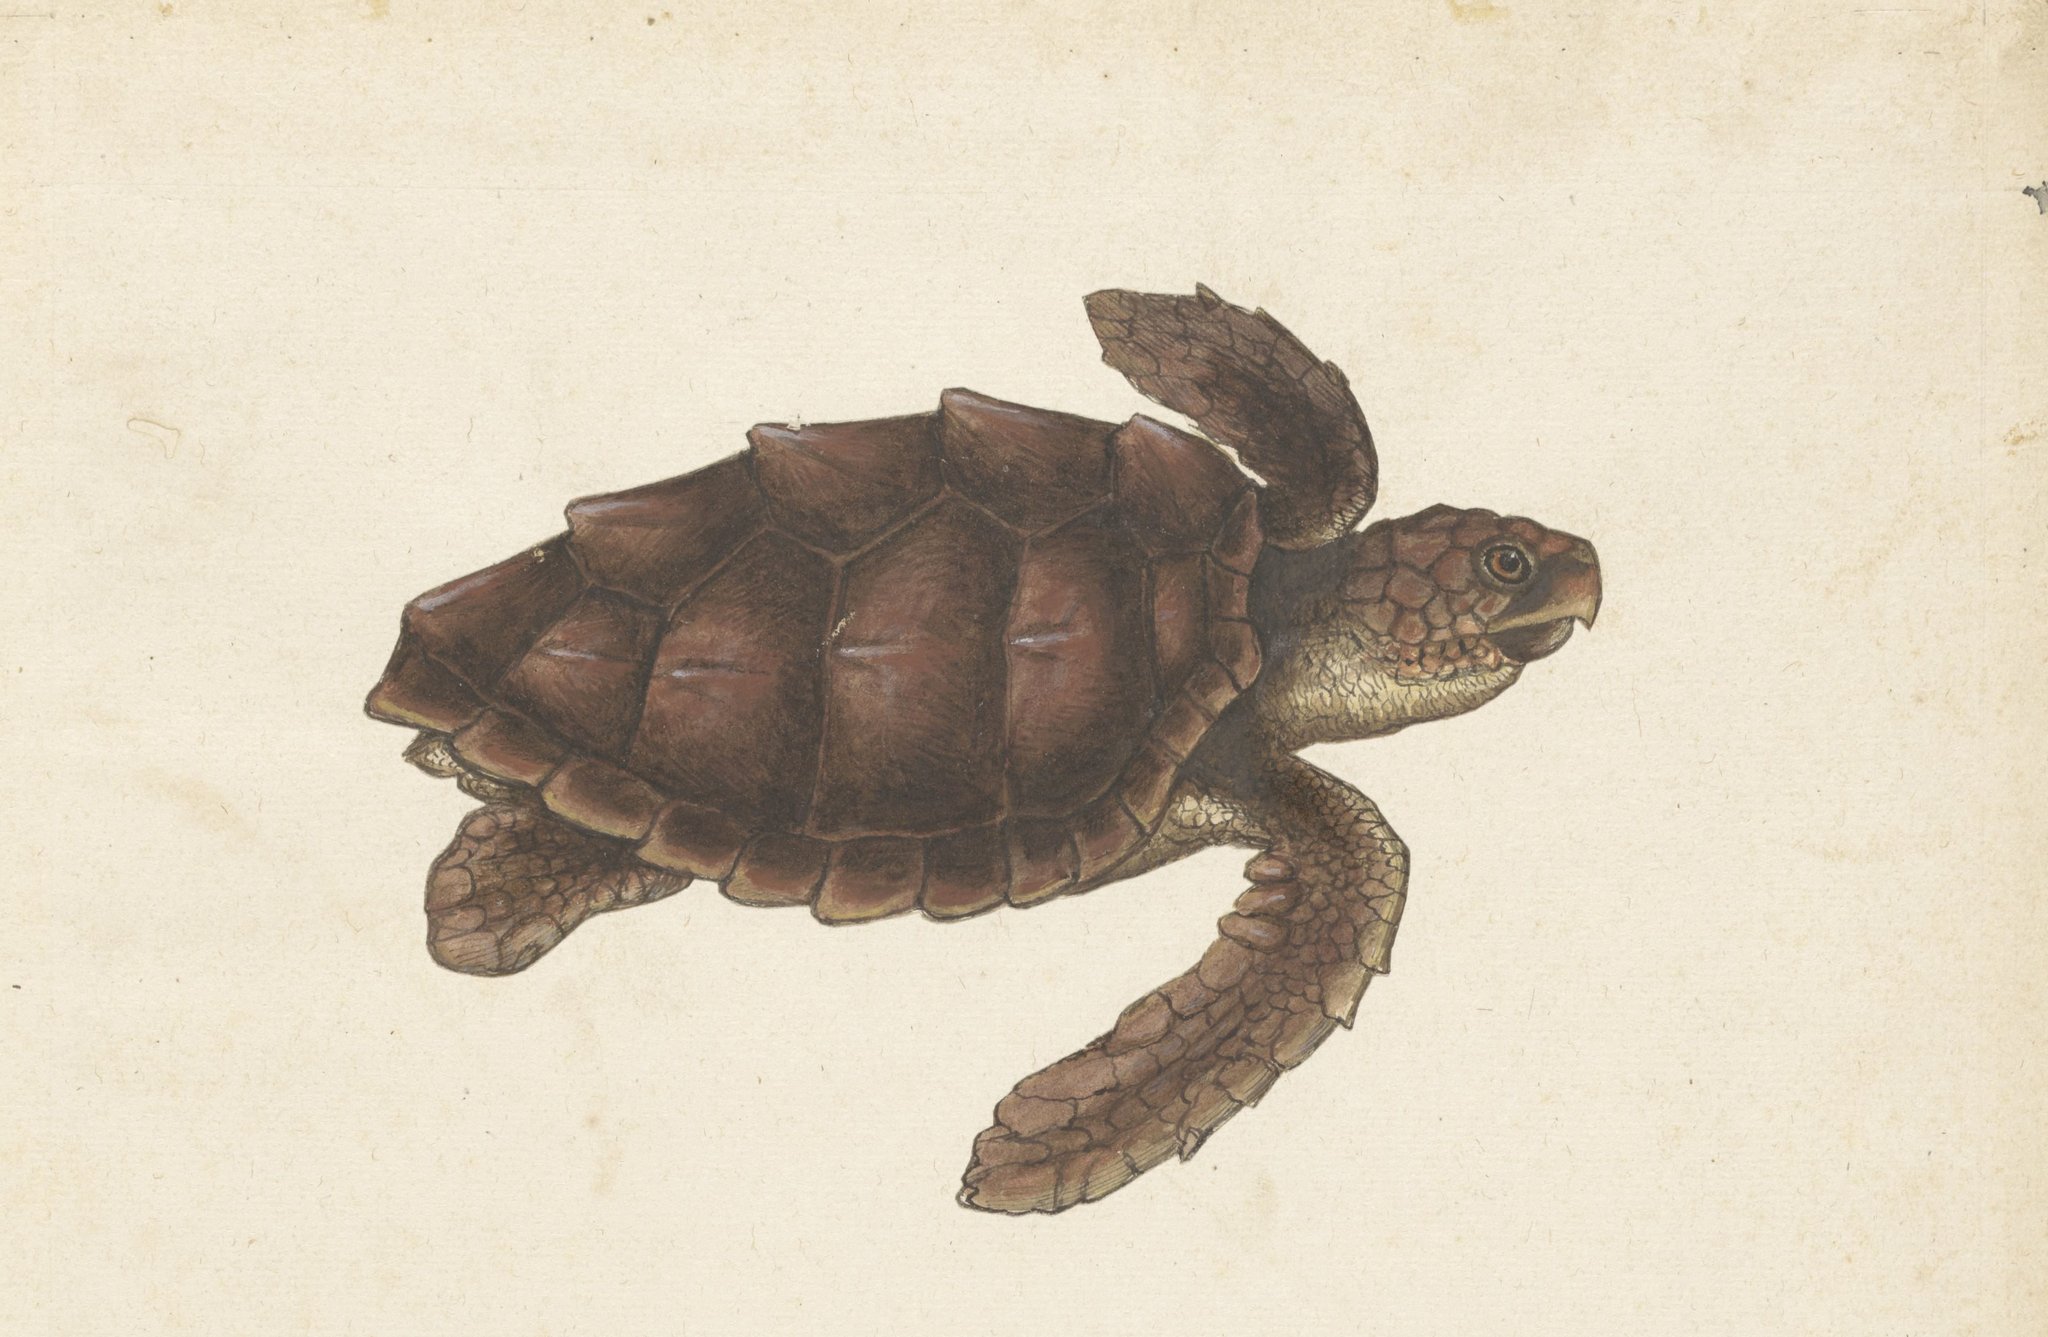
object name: drawing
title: Tortugas - Eretmochelys imbricata / Hawksbill Turtle / karetschildpad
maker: Anonymous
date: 1560-1585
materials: ink, paper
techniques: brush, pen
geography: low countries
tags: tortoises, turtles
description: Blad uit album van 100 (?) bladen met tekeningen van dieren.